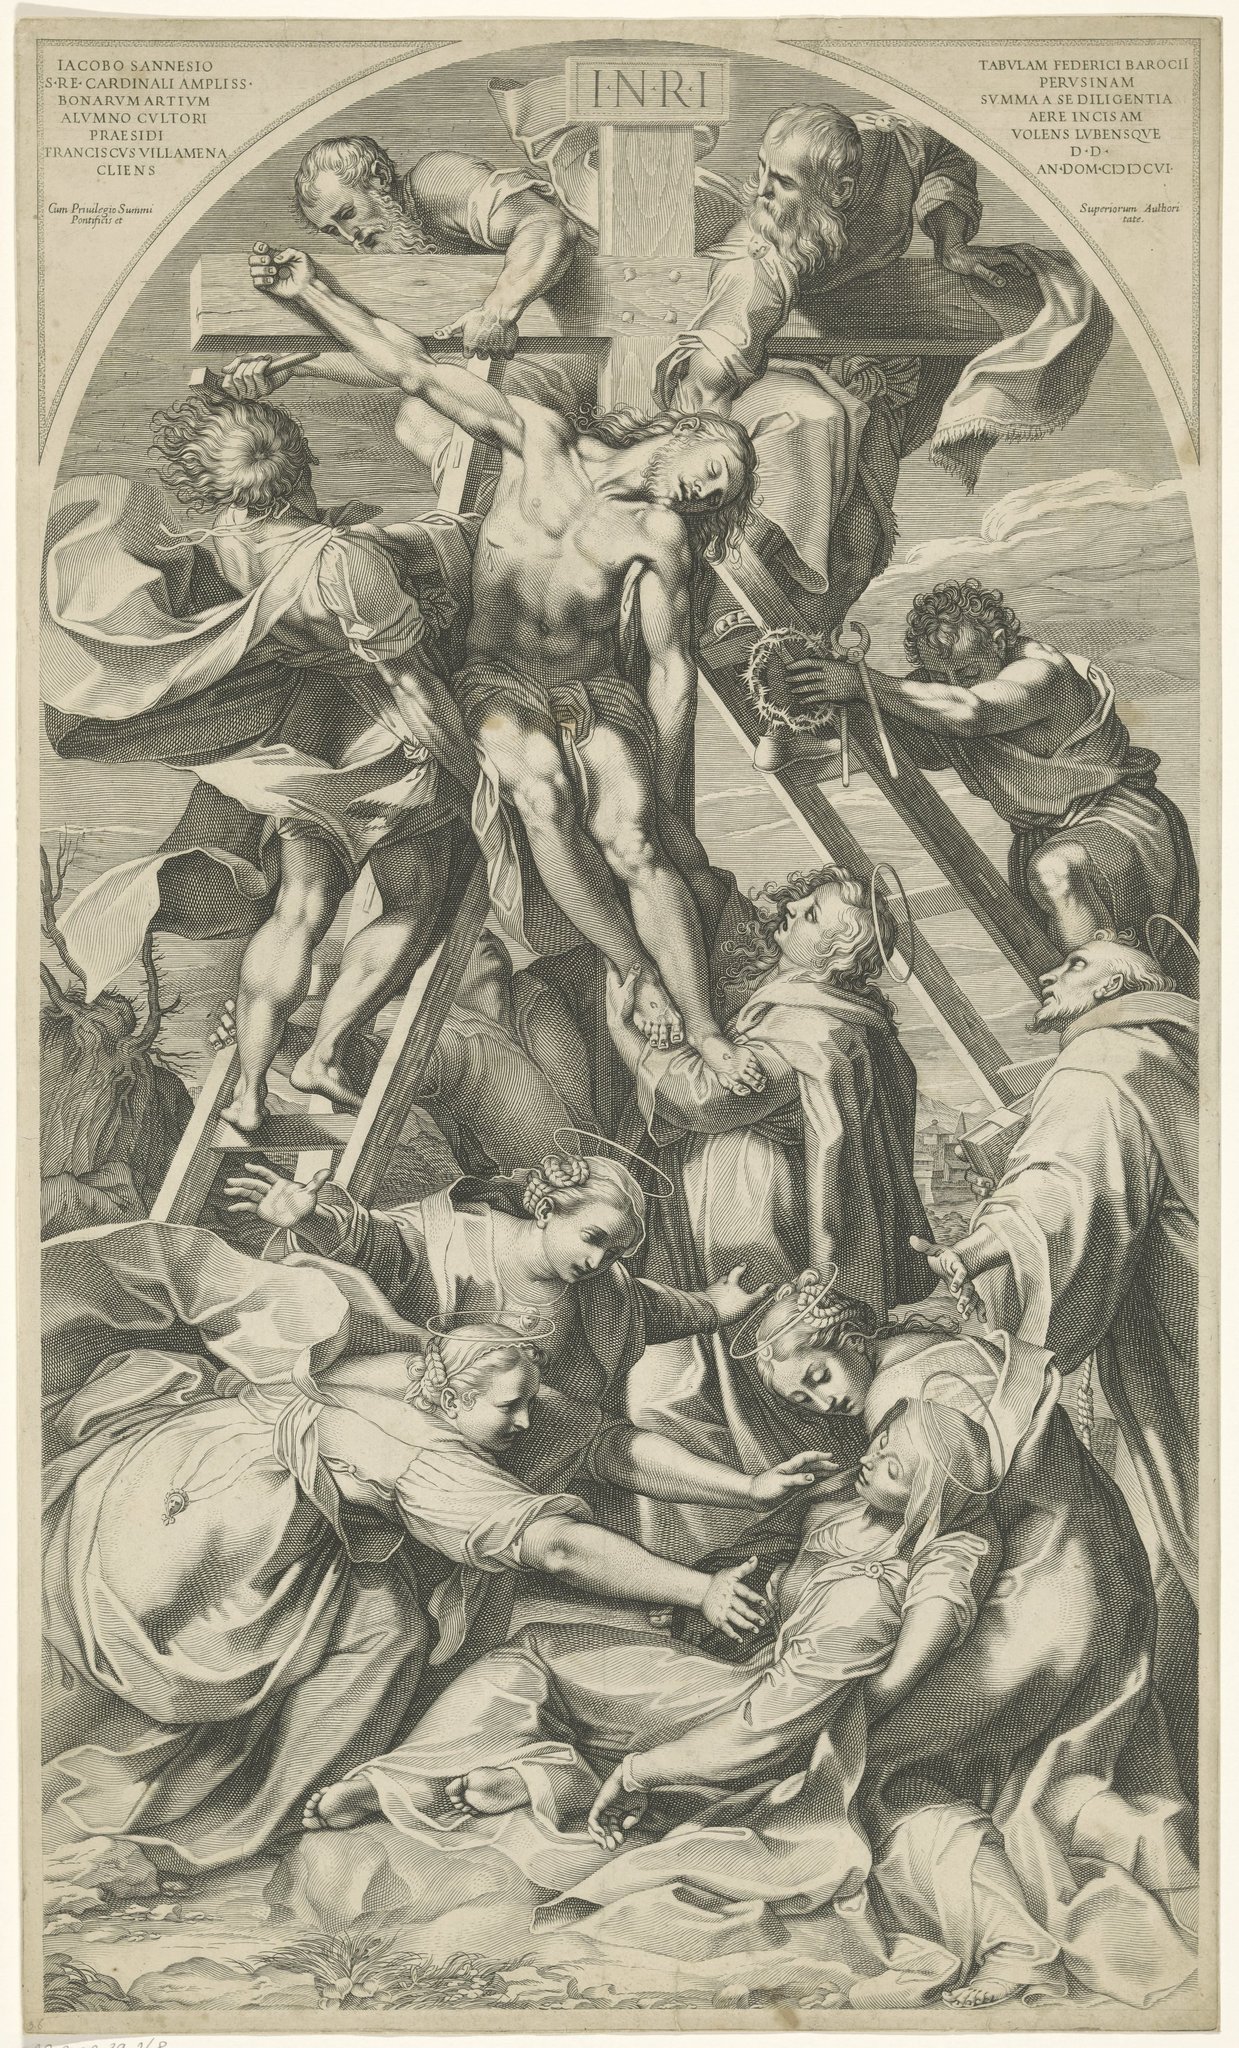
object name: print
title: Kruisafneming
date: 1576-1624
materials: paper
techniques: engraving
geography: vatican city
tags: descent from the cross: christ is taken down from the cross, usually by nicodemus and joseph of arimathaea who are standing on the ladders (both arms of christ detached)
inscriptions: collector's mark: Lugt 240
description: Het lichaam van Christus wordt van het kruis gehaald door Johannes de Evangelist, Jozef van Arimatea en Nikodemus. De Maria's treuren aan de voet van het kruis.